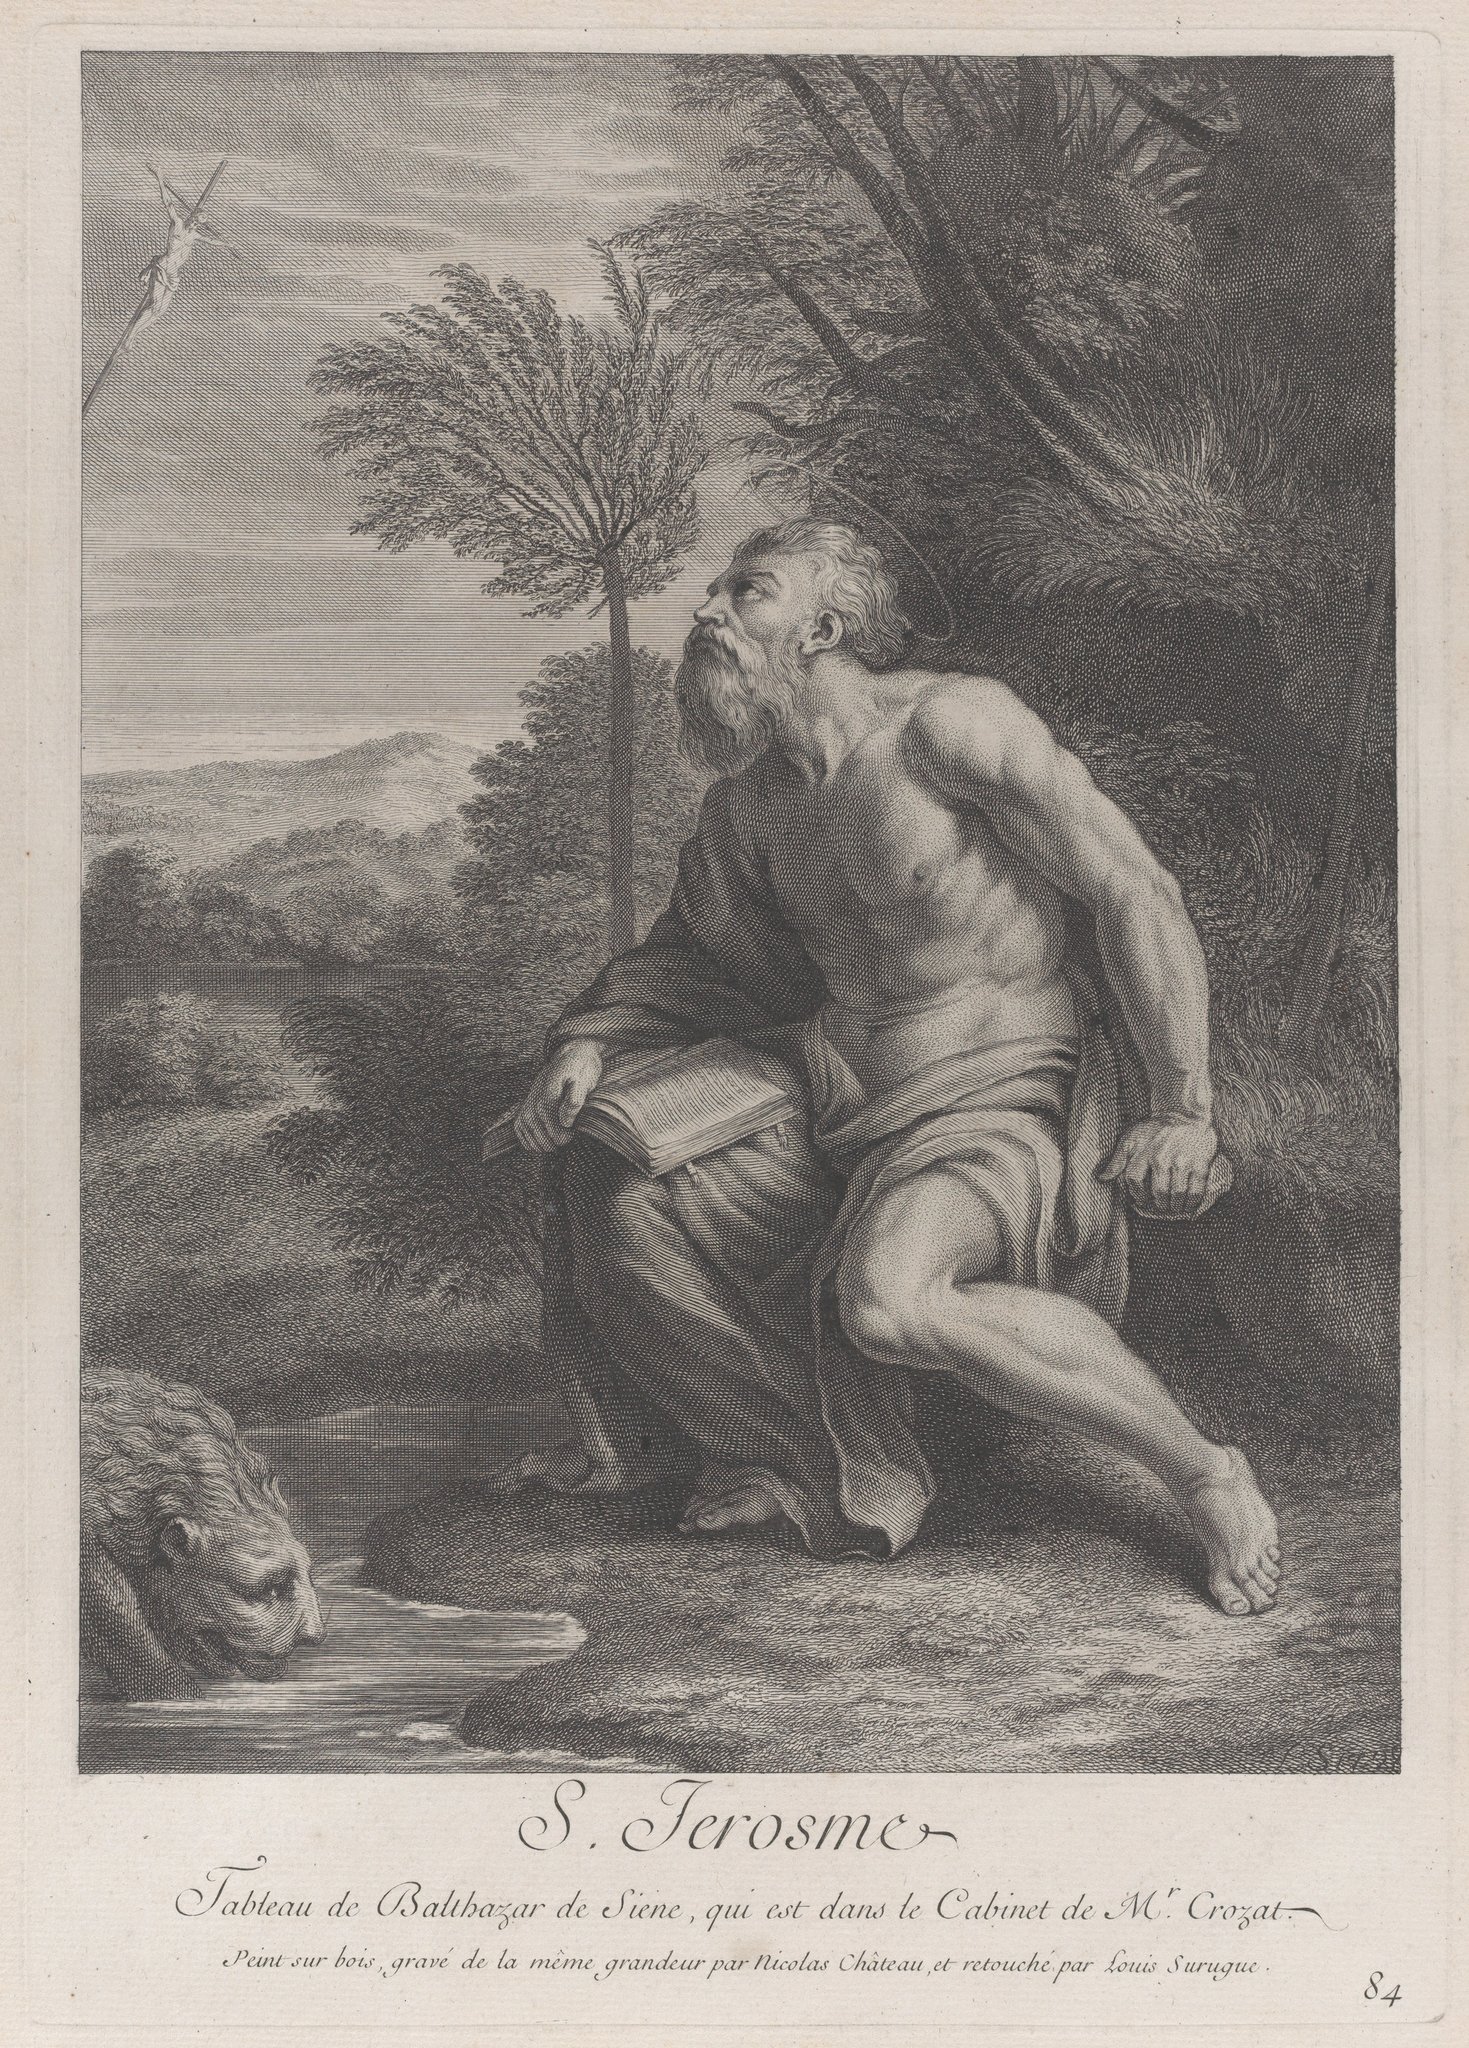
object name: print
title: Saint Jerome seated by a tree looking up at a crucifix, a lion drinking water from a stream to his right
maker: nicolas chasteau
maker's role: artist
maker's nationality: french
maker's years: 1680-1755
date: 1728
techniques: engraving, etching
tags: lions,saint jerome